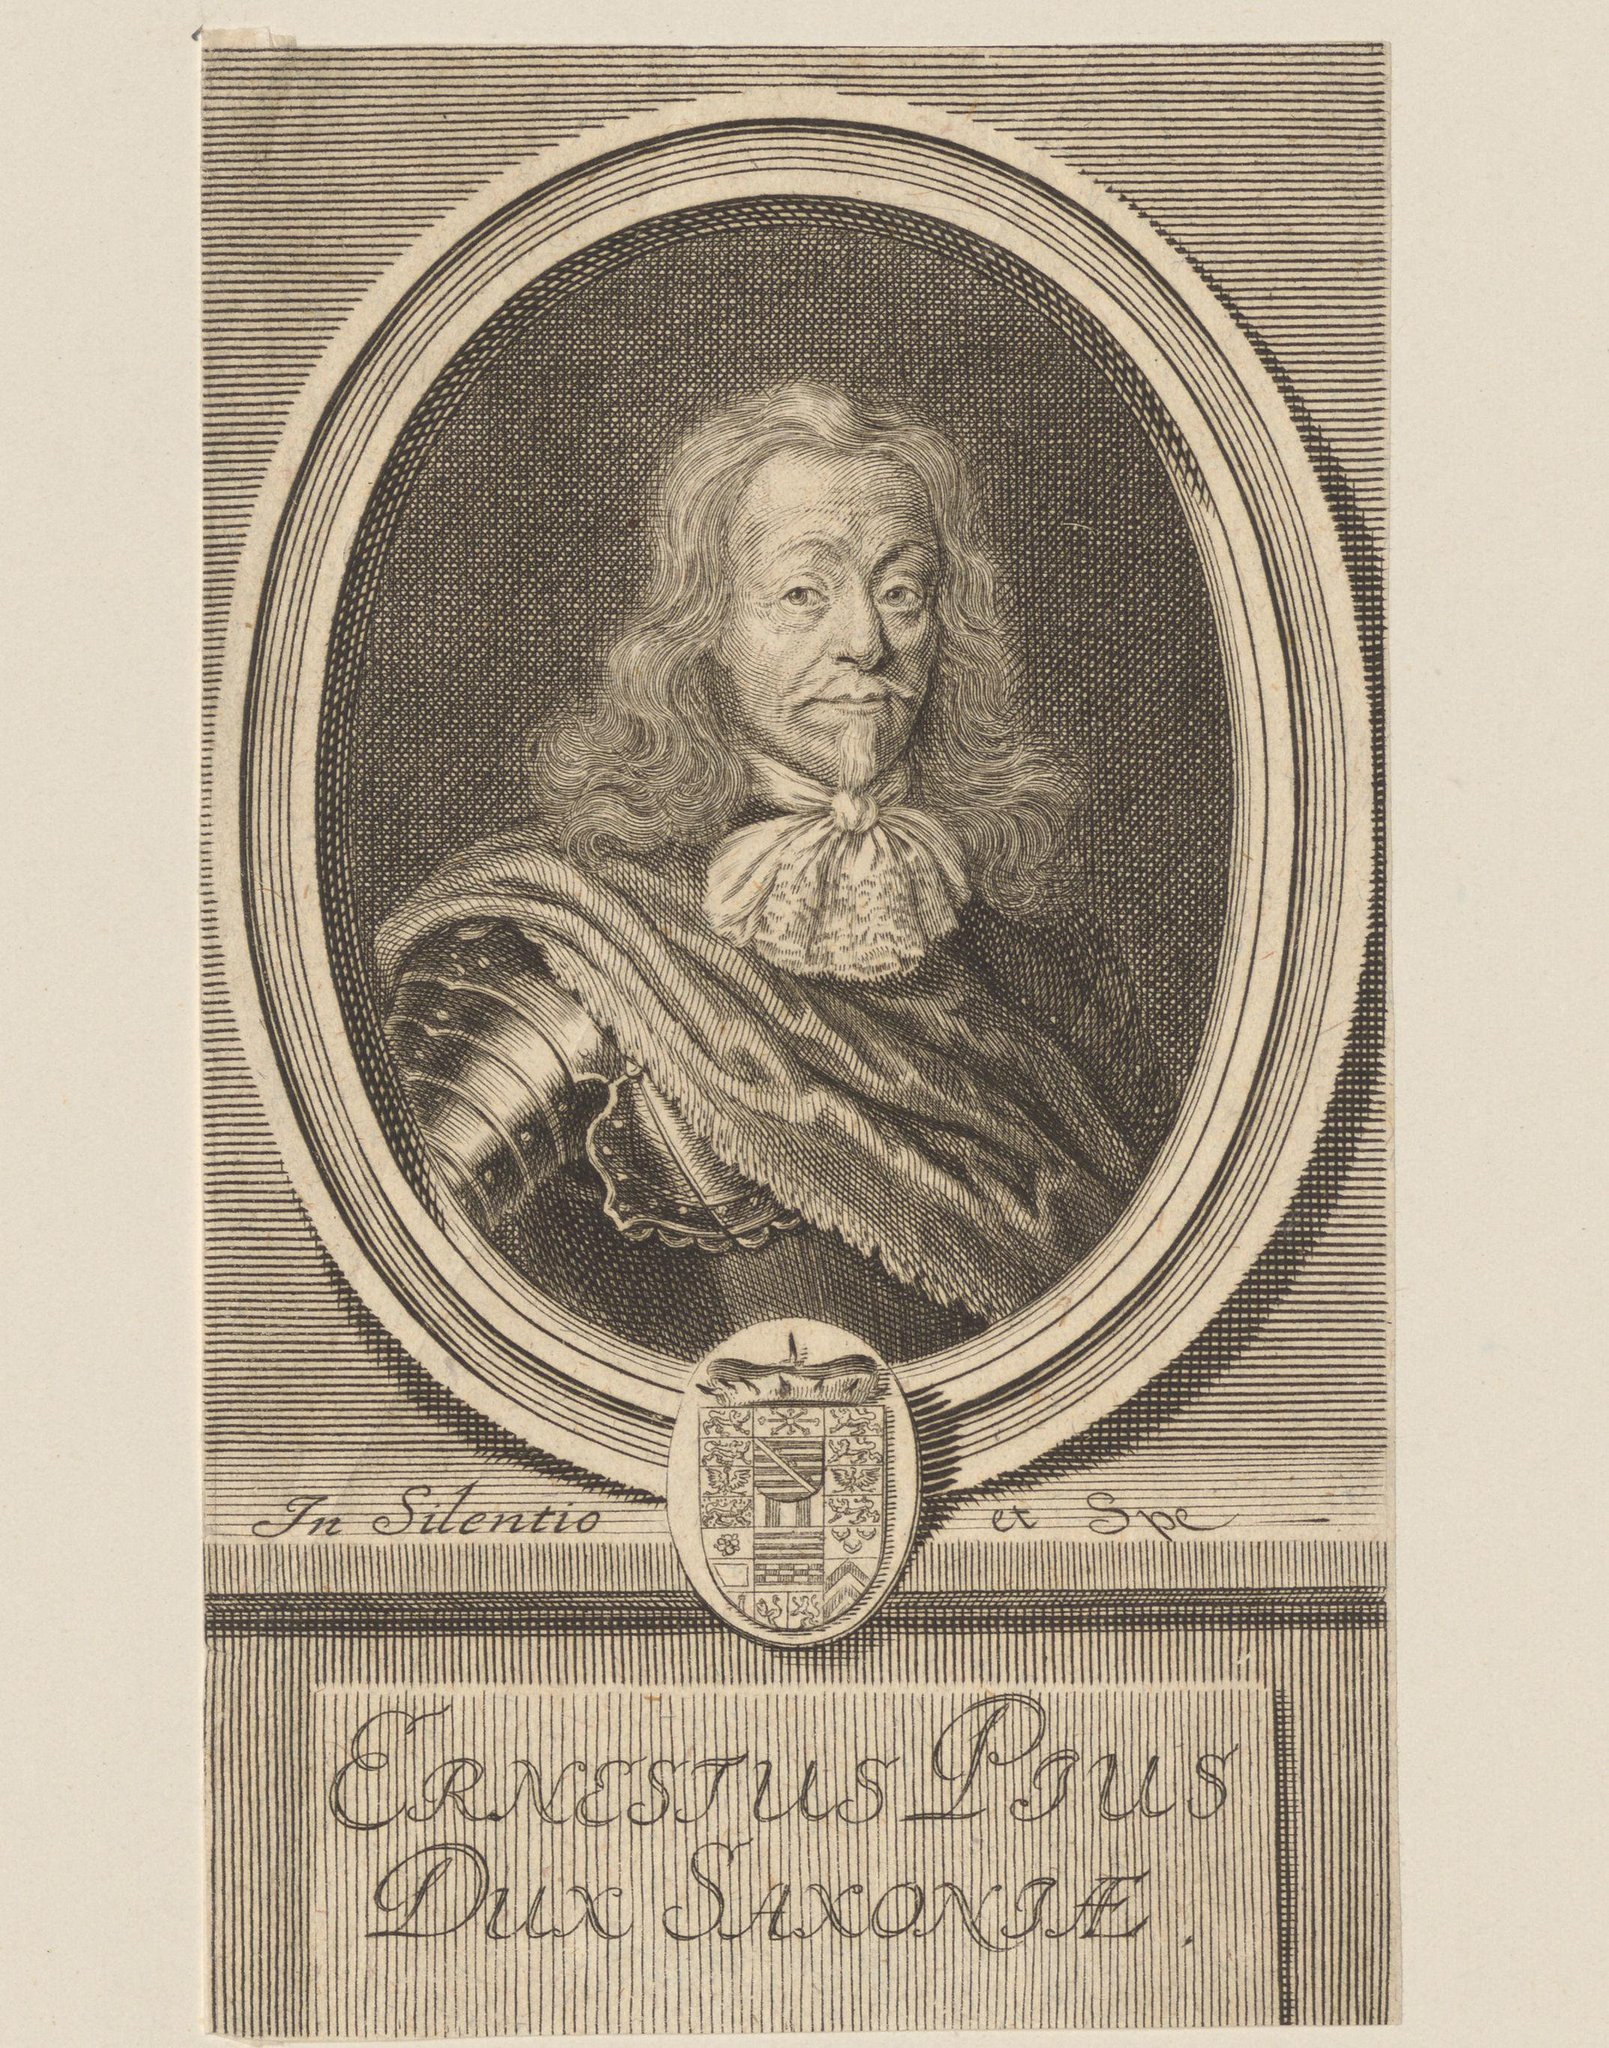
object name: print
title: Portret van Ernst I van Saksen-Gotha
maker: Anonymous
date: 1700-1750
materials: paper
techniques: engraving, etching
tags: historical persons, armorial bearing, heraldry